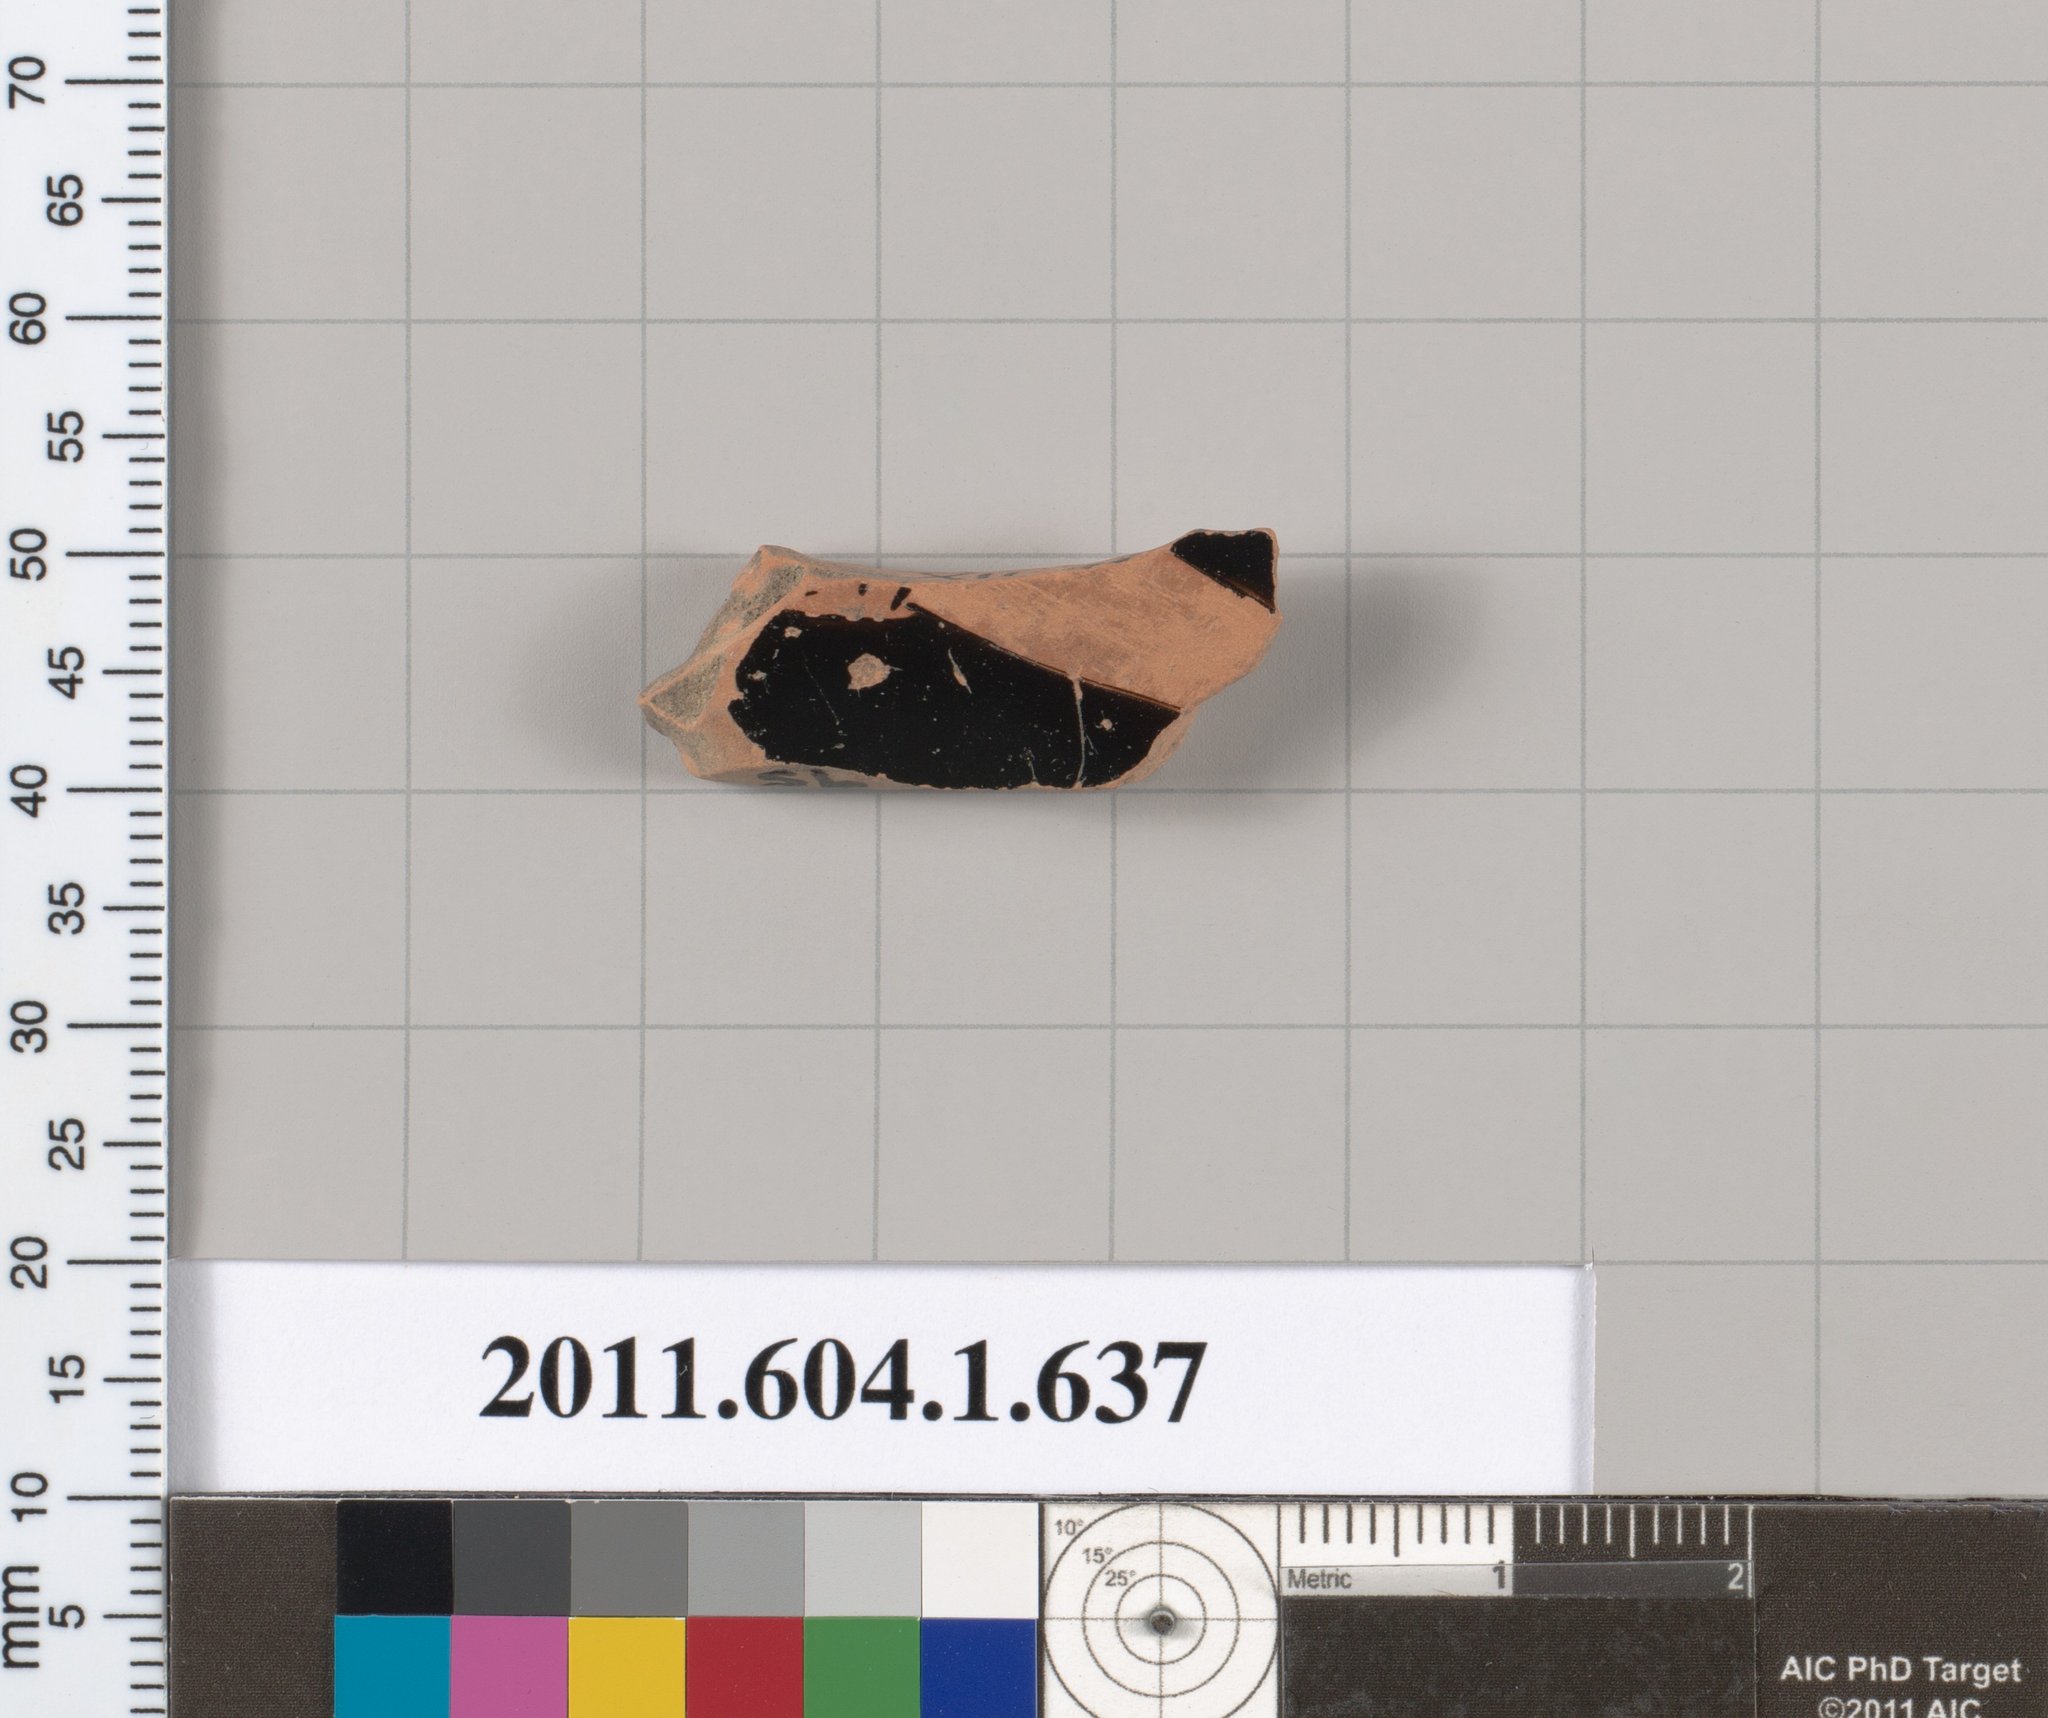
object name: kylix fragment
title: Terracotta fragment of a kylix (drinking cup)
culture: greek, attic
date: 475-451 BCE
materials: terracotta